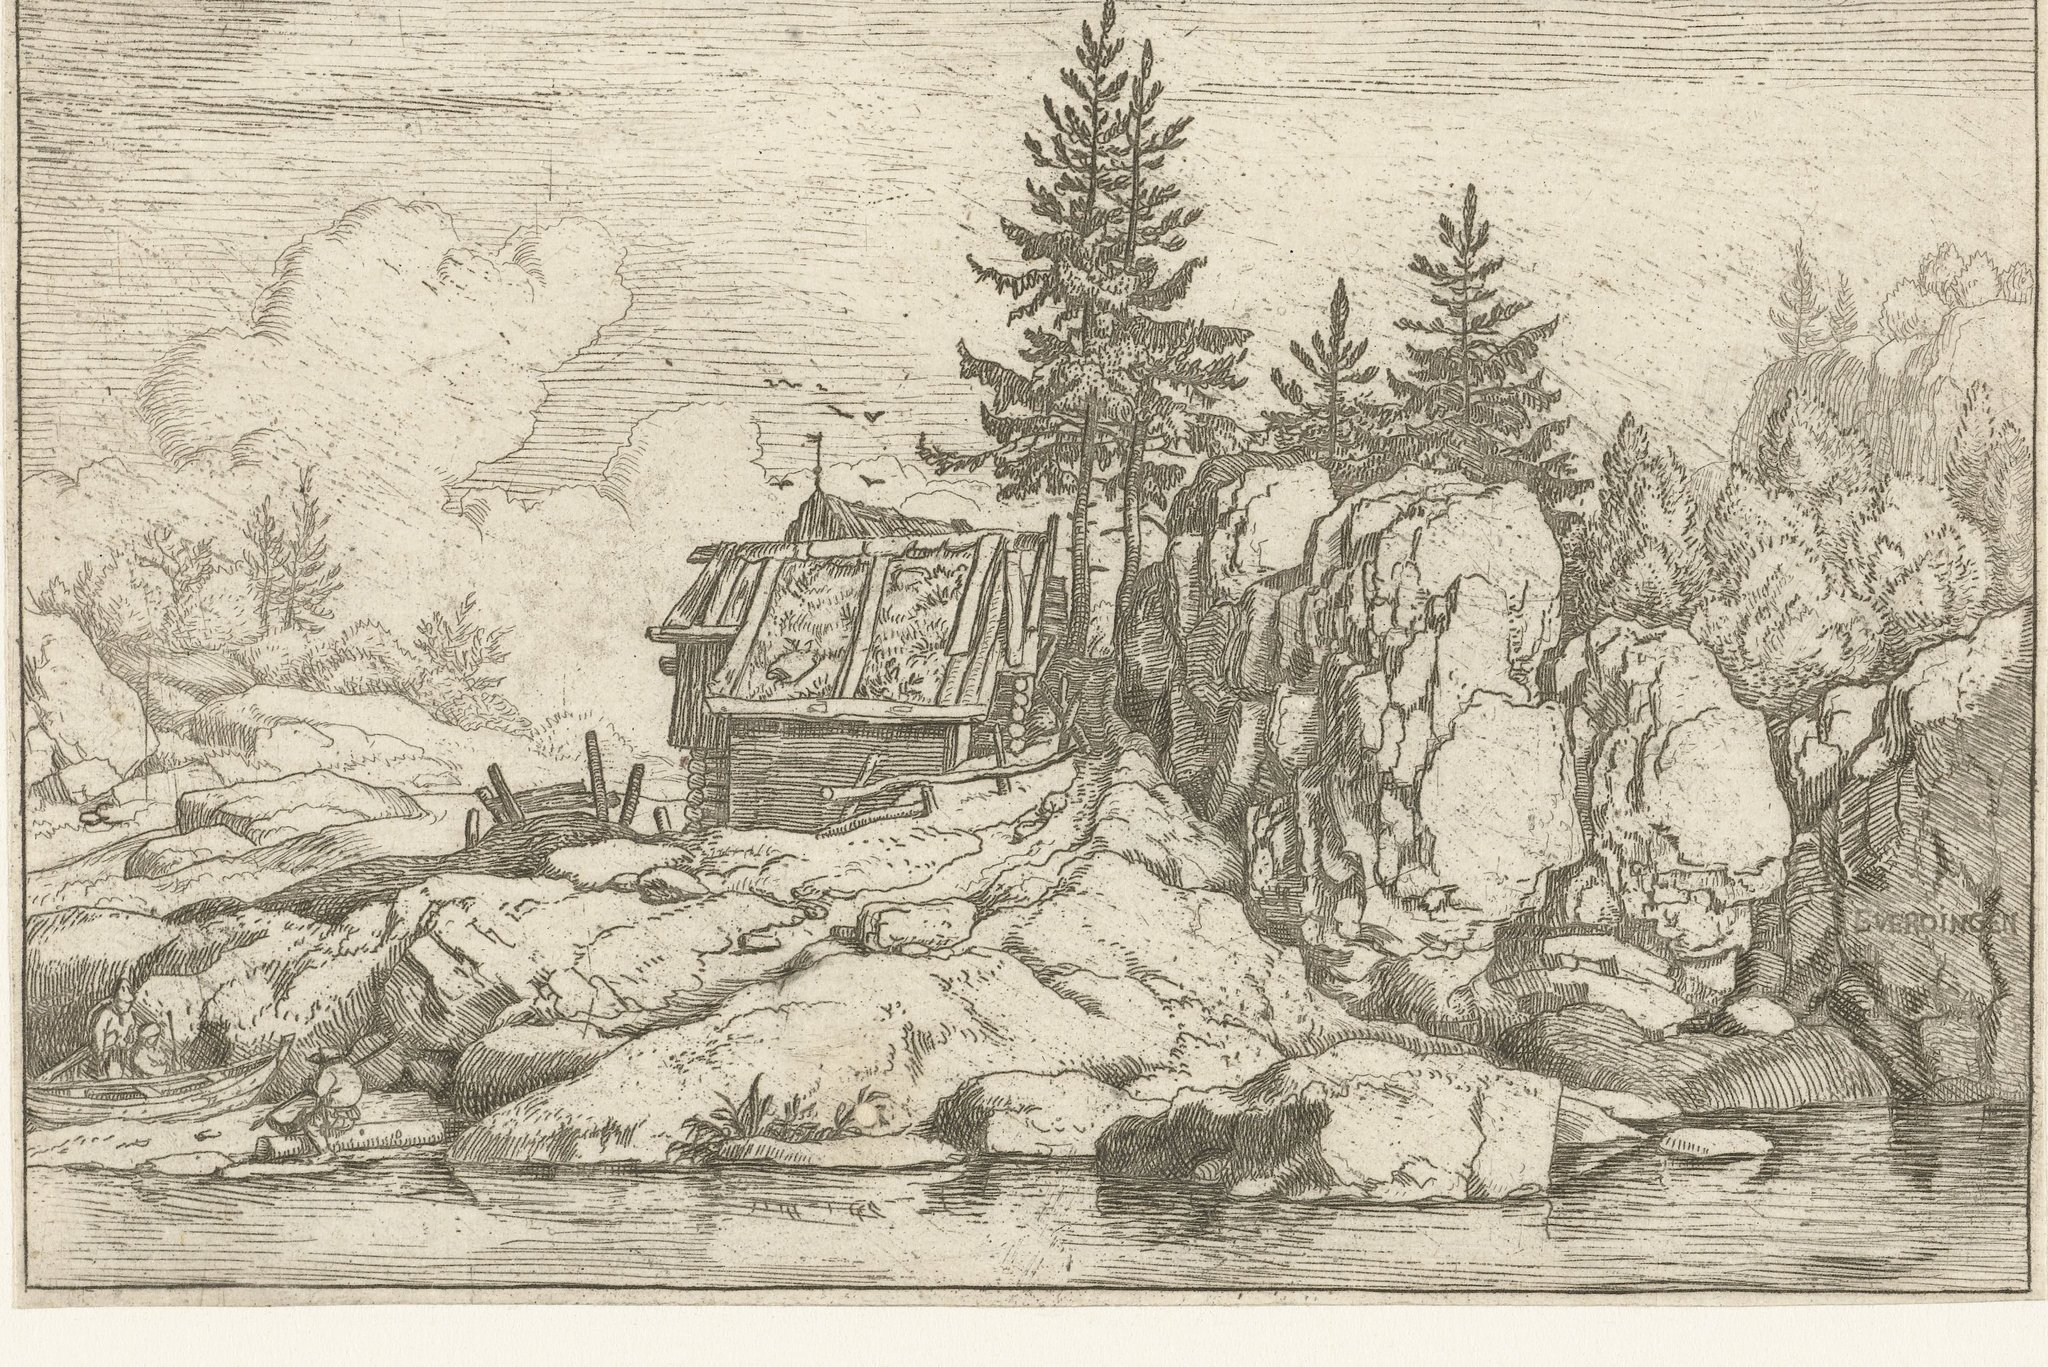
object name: print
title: Twee pijnbomen naast een paar huizen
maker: allaert van everdingen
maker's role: draughtsman, painter, print maker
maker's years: 1621-1675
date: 1631-1675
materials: paper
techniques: etching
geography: netherlands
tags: farm or solitary house in landscape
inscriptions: collector's mark: Lugt 2228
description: Rotslandschap met vier sparren naast een houten hut met rieten dak. Op de oever op de voorgrond vier personen en een roeiboot.